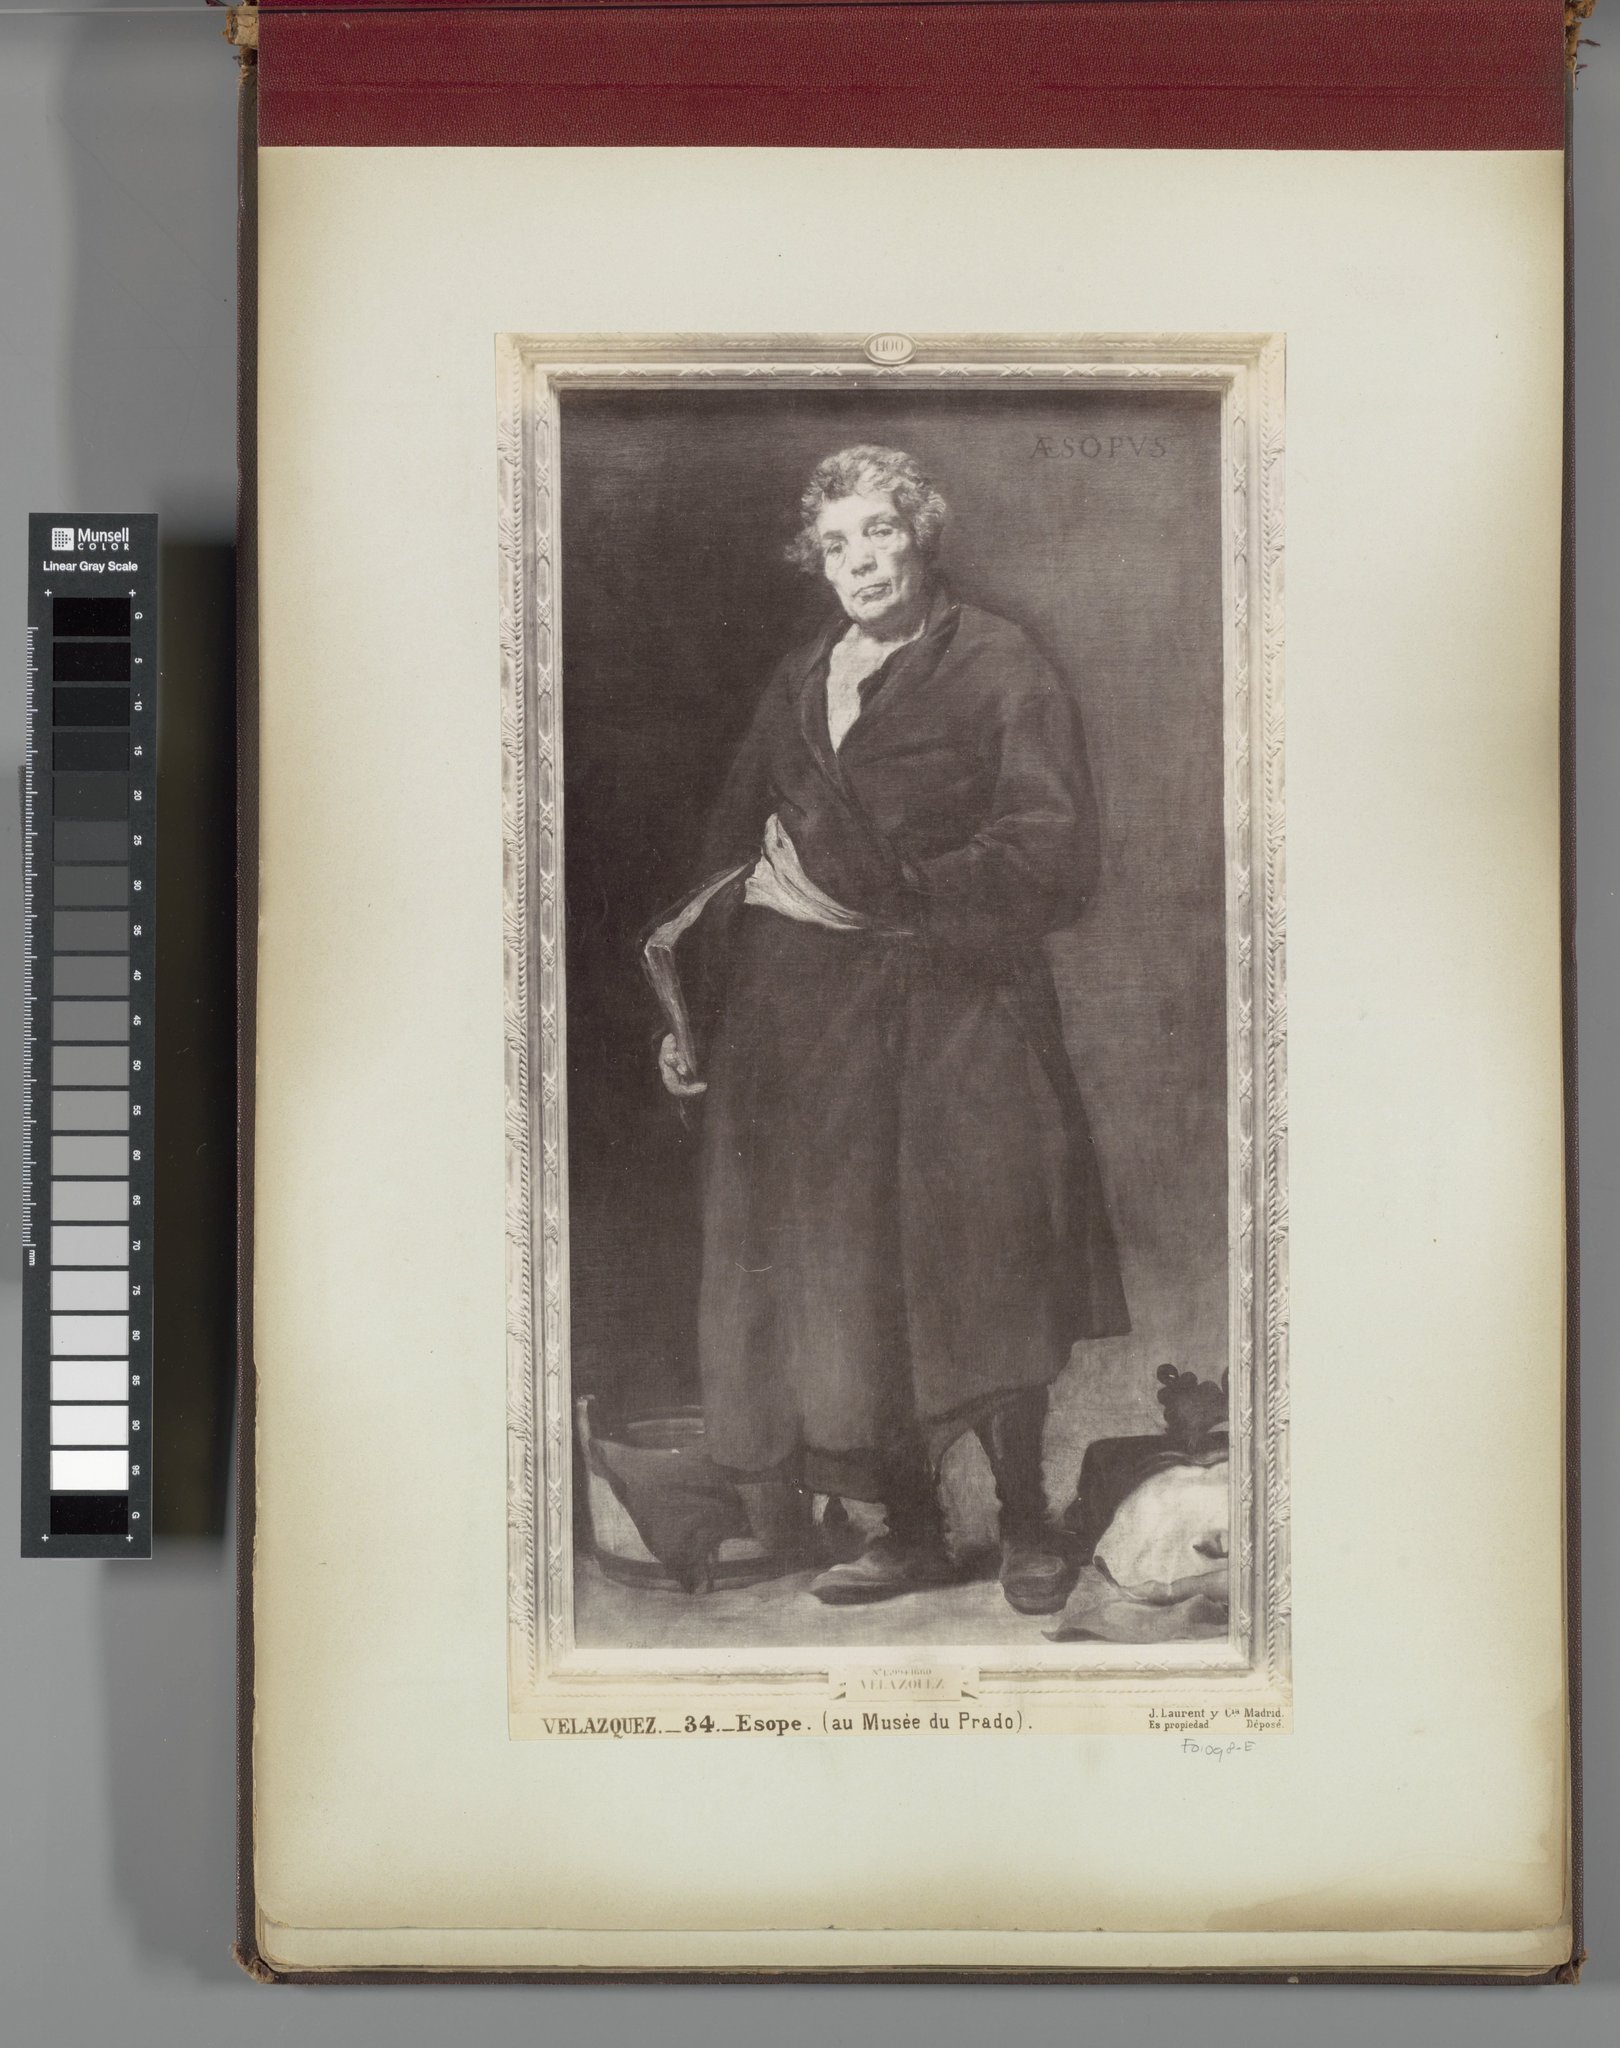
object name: reproduction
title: VELAZQUEZ.- Esope. (au Musée du Prado).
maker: juan laurent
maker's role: publisher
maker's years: 1816-1896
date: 1857-1880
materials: cardboard, paper, photographic support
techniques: albumen print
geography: madrid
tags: adult man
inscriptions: negative number: ‘34’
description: Onderdeel van Reisalbum met foto's van bezienswaardigheden in Spanje en Marokko.